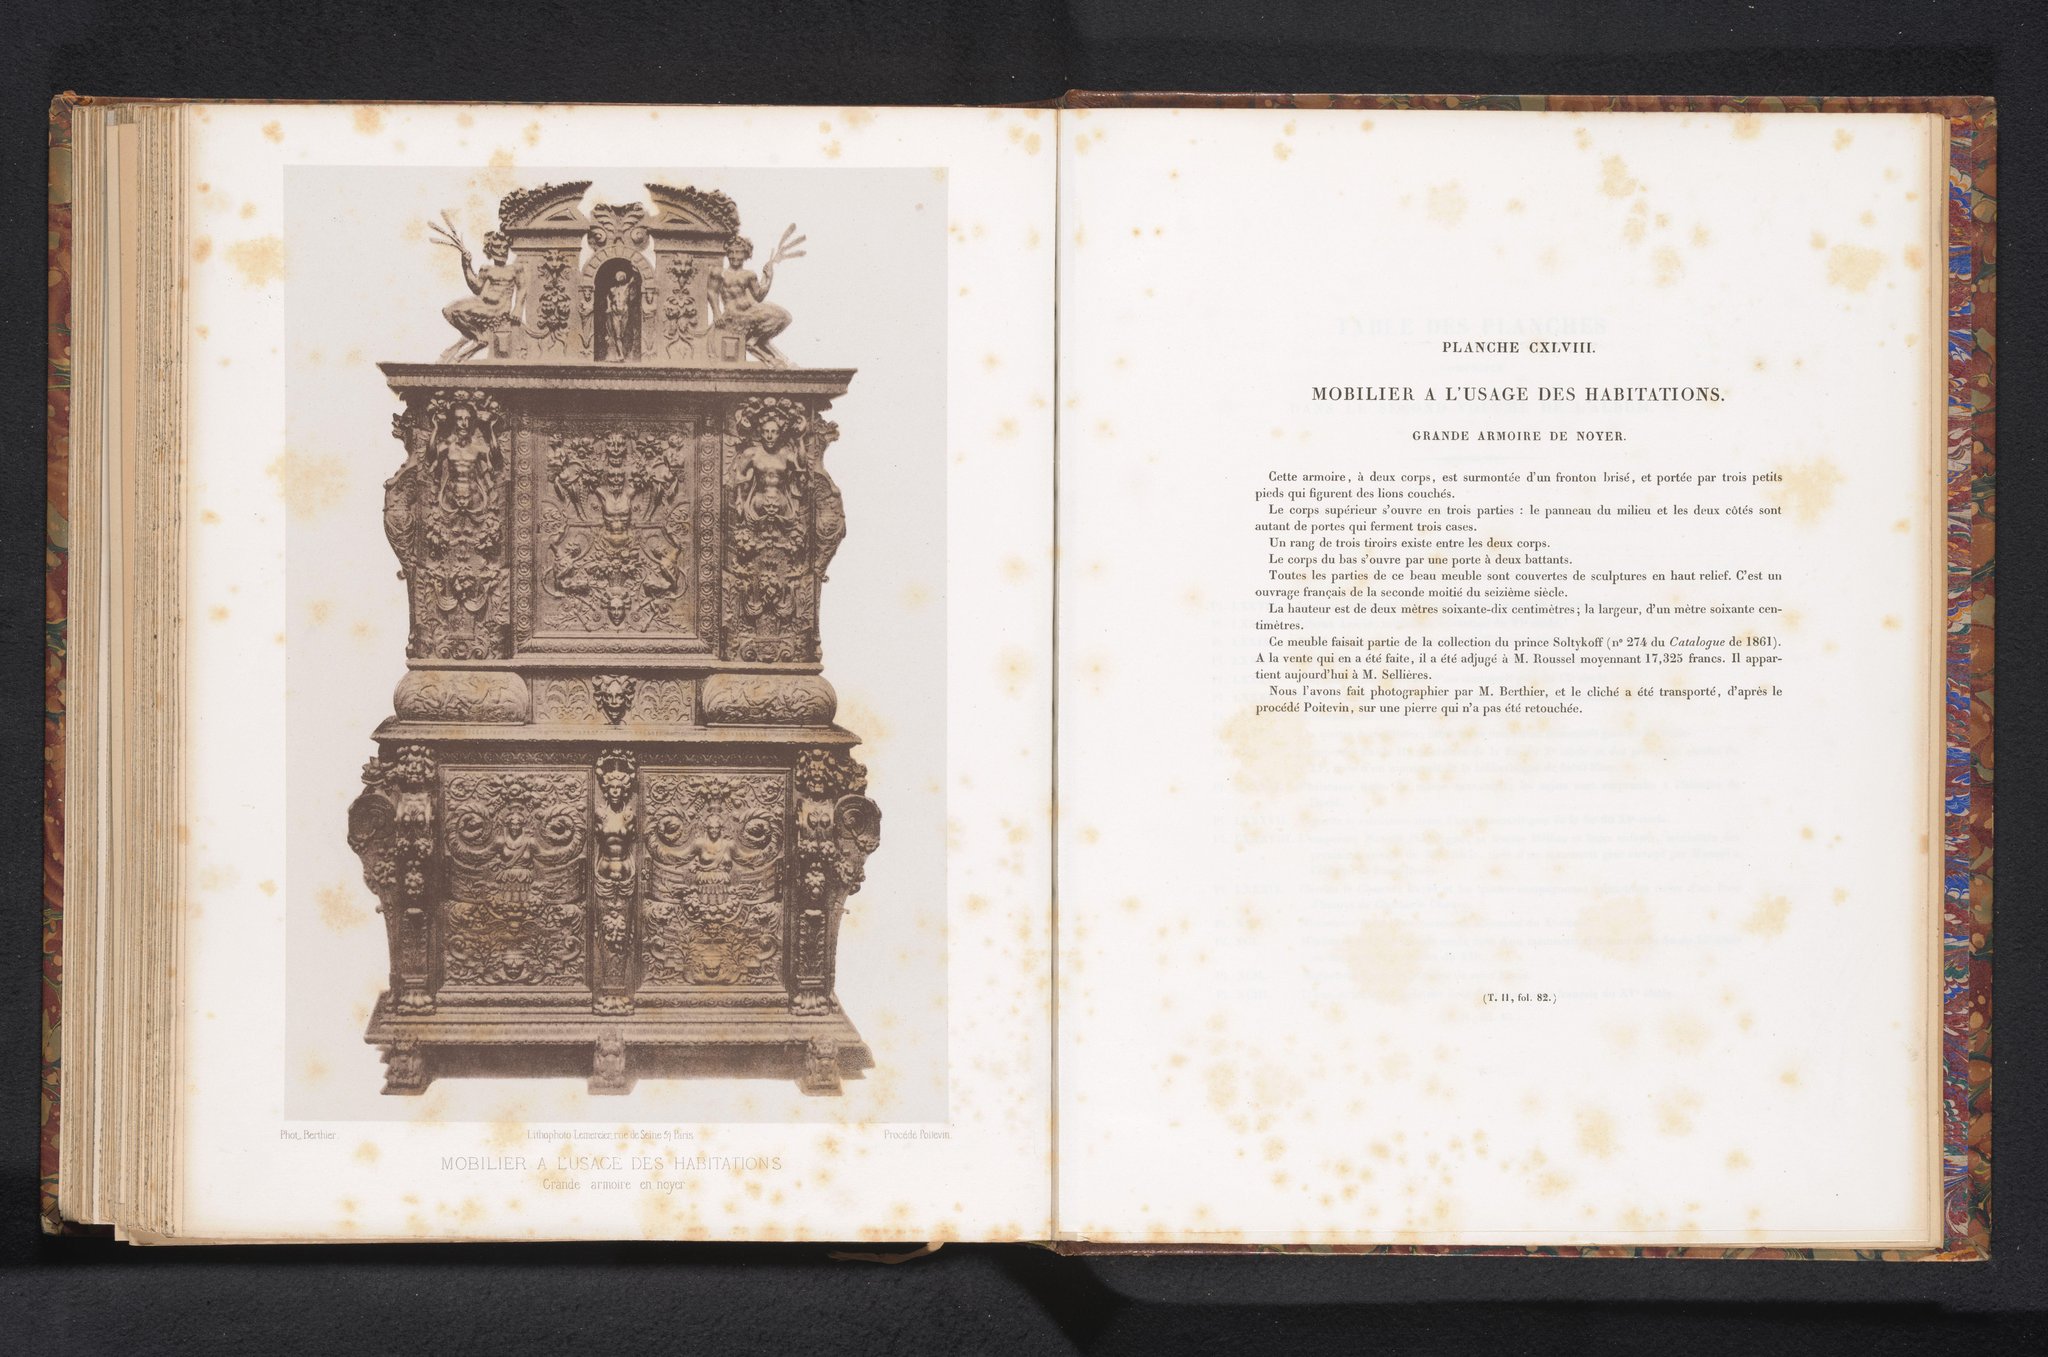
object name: reproduction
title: Reproductie van een gedecoreerde houten kast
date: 1859-1864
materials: paper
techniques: photolithography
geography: paris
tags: furniture for storage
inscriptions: name: ‘Phot. Berthier./ Procédé Poitevin’